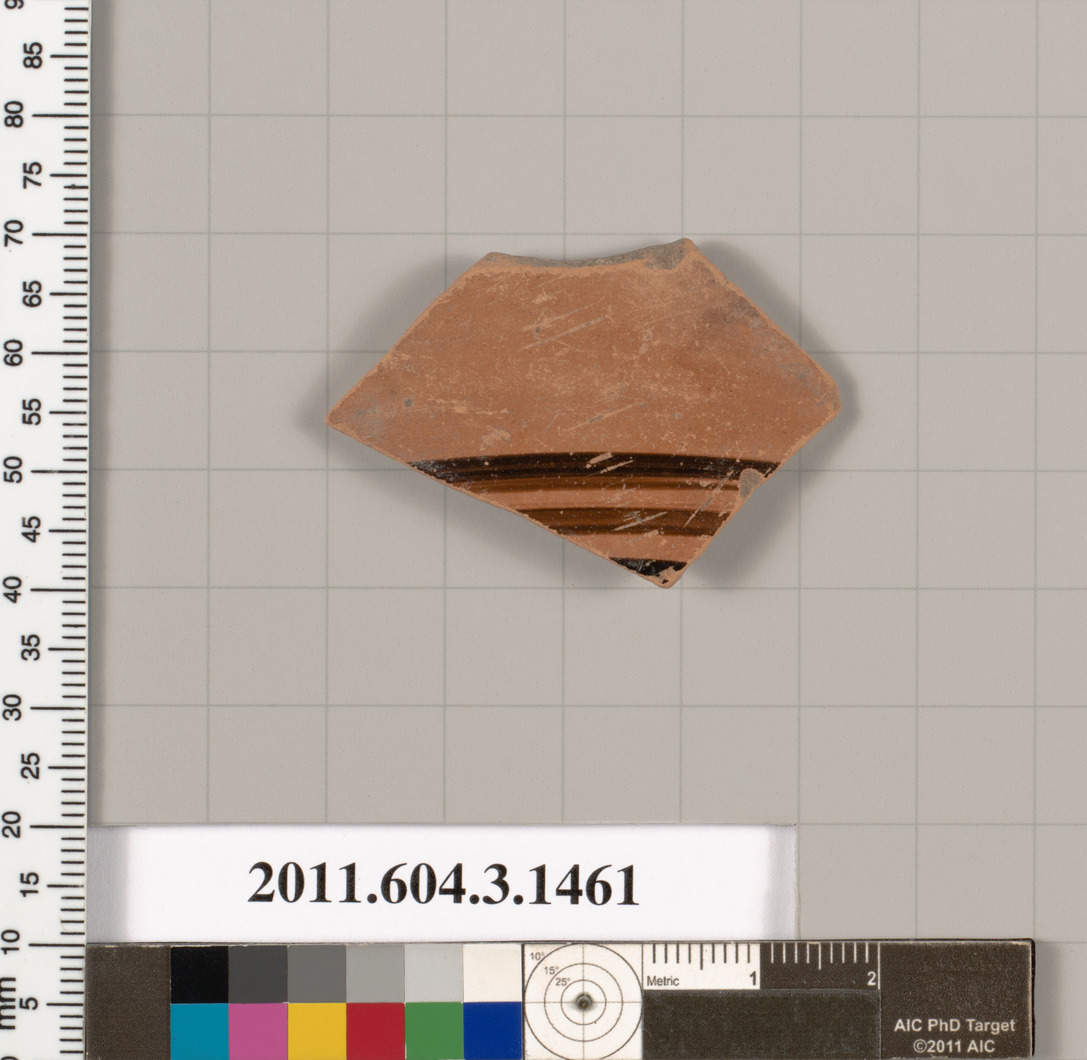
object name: skyphos fragment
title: Terracotta fragment of a skyphos (deep drinking cup)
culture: greek, attic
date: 600-401 BCE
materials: terracotta